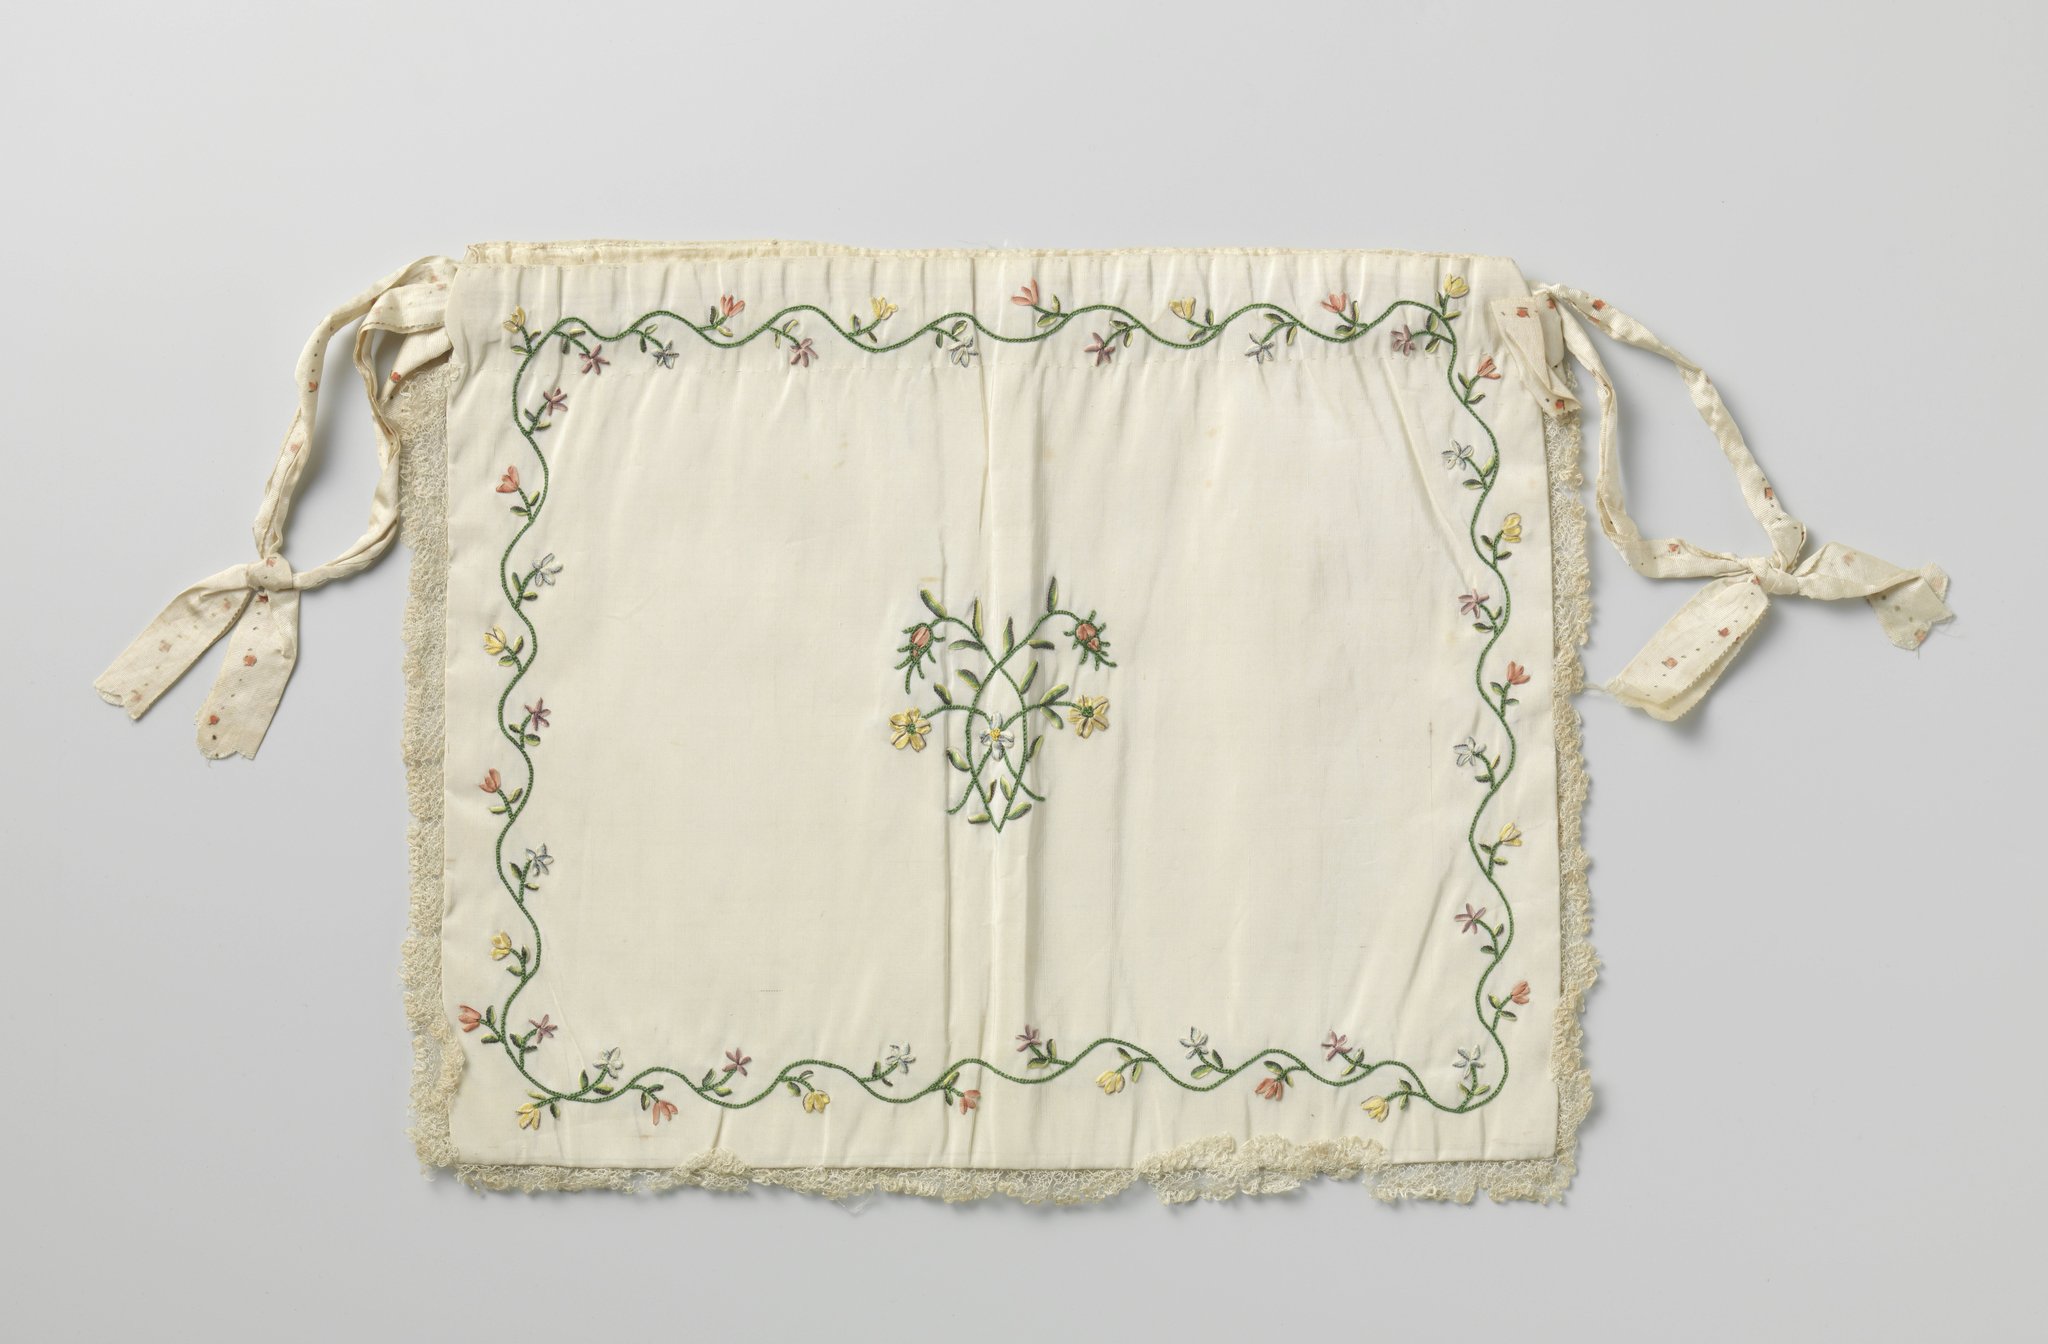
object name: bag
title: Frivolitétas in rechthoekig model van ivoorkleurig tafzijde, waarop angs de rand een bloemenslinger lgeborduurd met kleurige linten, met zijden kloskant omboord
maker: Anonymous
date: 1770-1790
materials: paint, silk, watercolor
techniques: lace, embroidered, weave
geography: netherlands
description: Tas in een plat en rechthoekig model van ivoorkleurig tafzijde, waarop aan beide kanten langs de rand een ijle bloemenslinger geborduurd met kleurige linten en vloszijde. Centraal in het midden een compositie van takken en vijf bloemen in roze, blauw en geel. De tas is met zijden kloskant omboord en gevoerd met ivoorkleurige zijde. Aan de bovenkant is een opening die met linten van ripszijde dichtgetrokken kan worden. Op de linten stippen en rode bloemknoppen geschilderd.